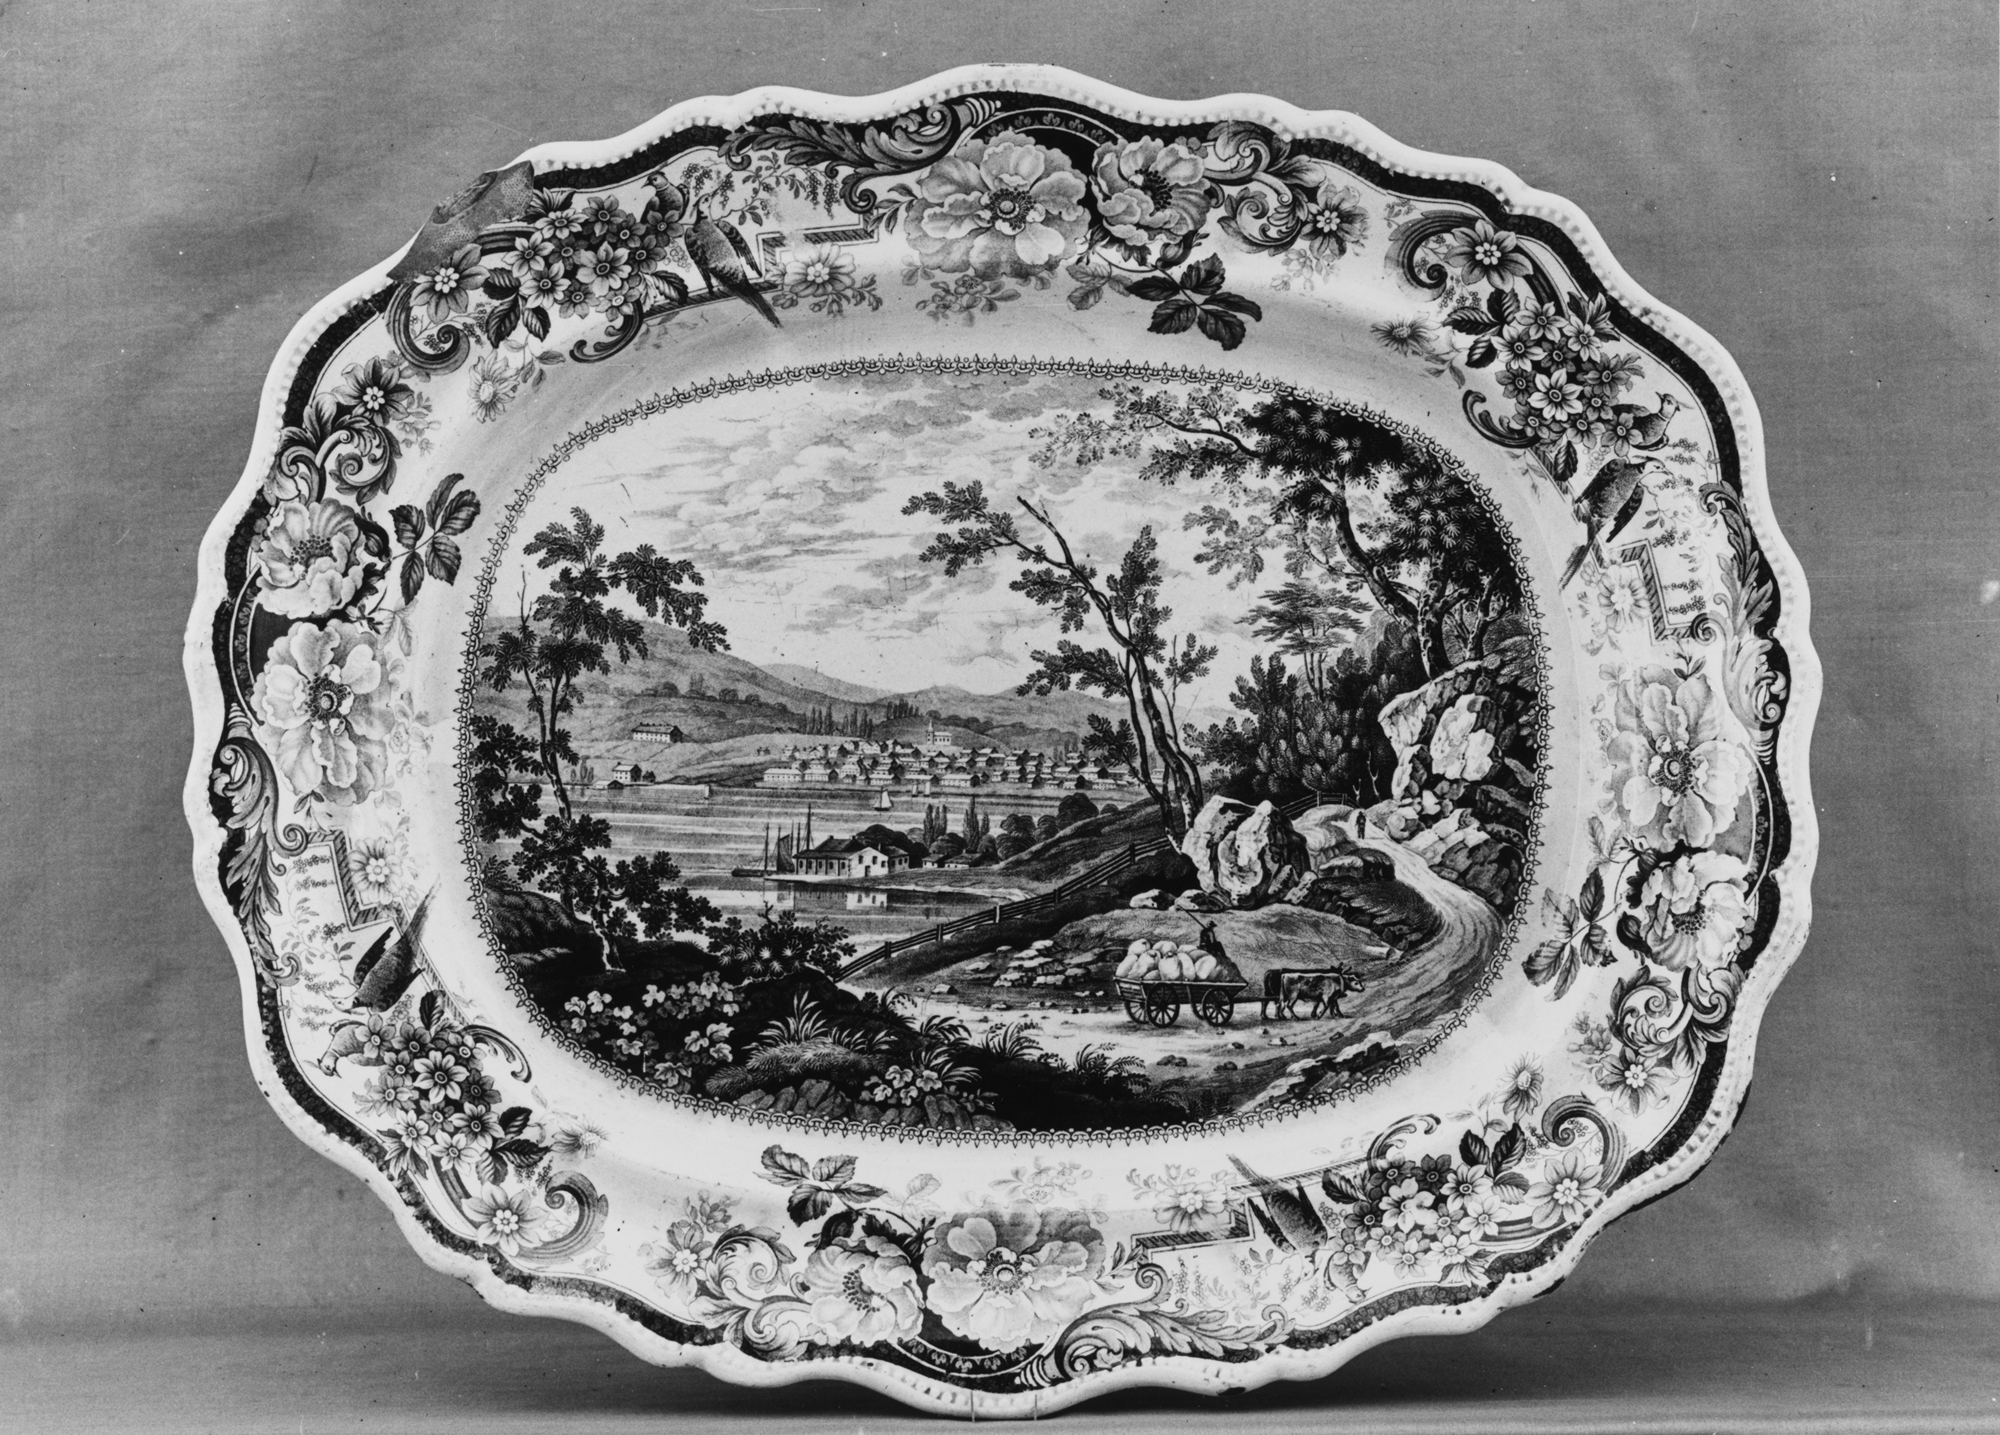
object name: platter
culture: british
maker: james and ralph clews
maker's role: maker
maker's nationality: british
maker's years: 1813-1836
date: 1825-1834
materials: earthenware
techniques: transfer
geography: england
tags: flowers,landscapes